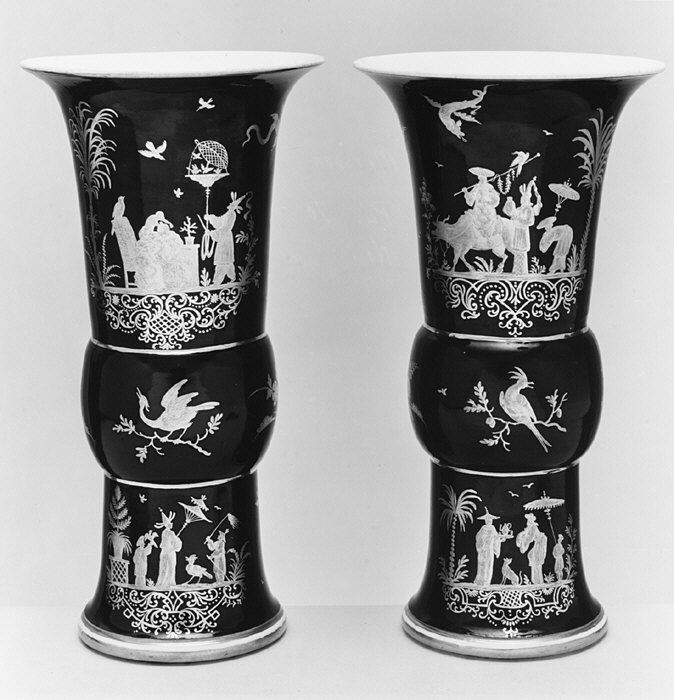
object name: beaker vase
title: Pair of beaker vases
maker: meissen manufactory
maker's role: manufactory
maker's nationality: german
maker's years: 1710-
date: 1730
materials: hard paste porcelain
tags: human figures,birds,chinoiserie